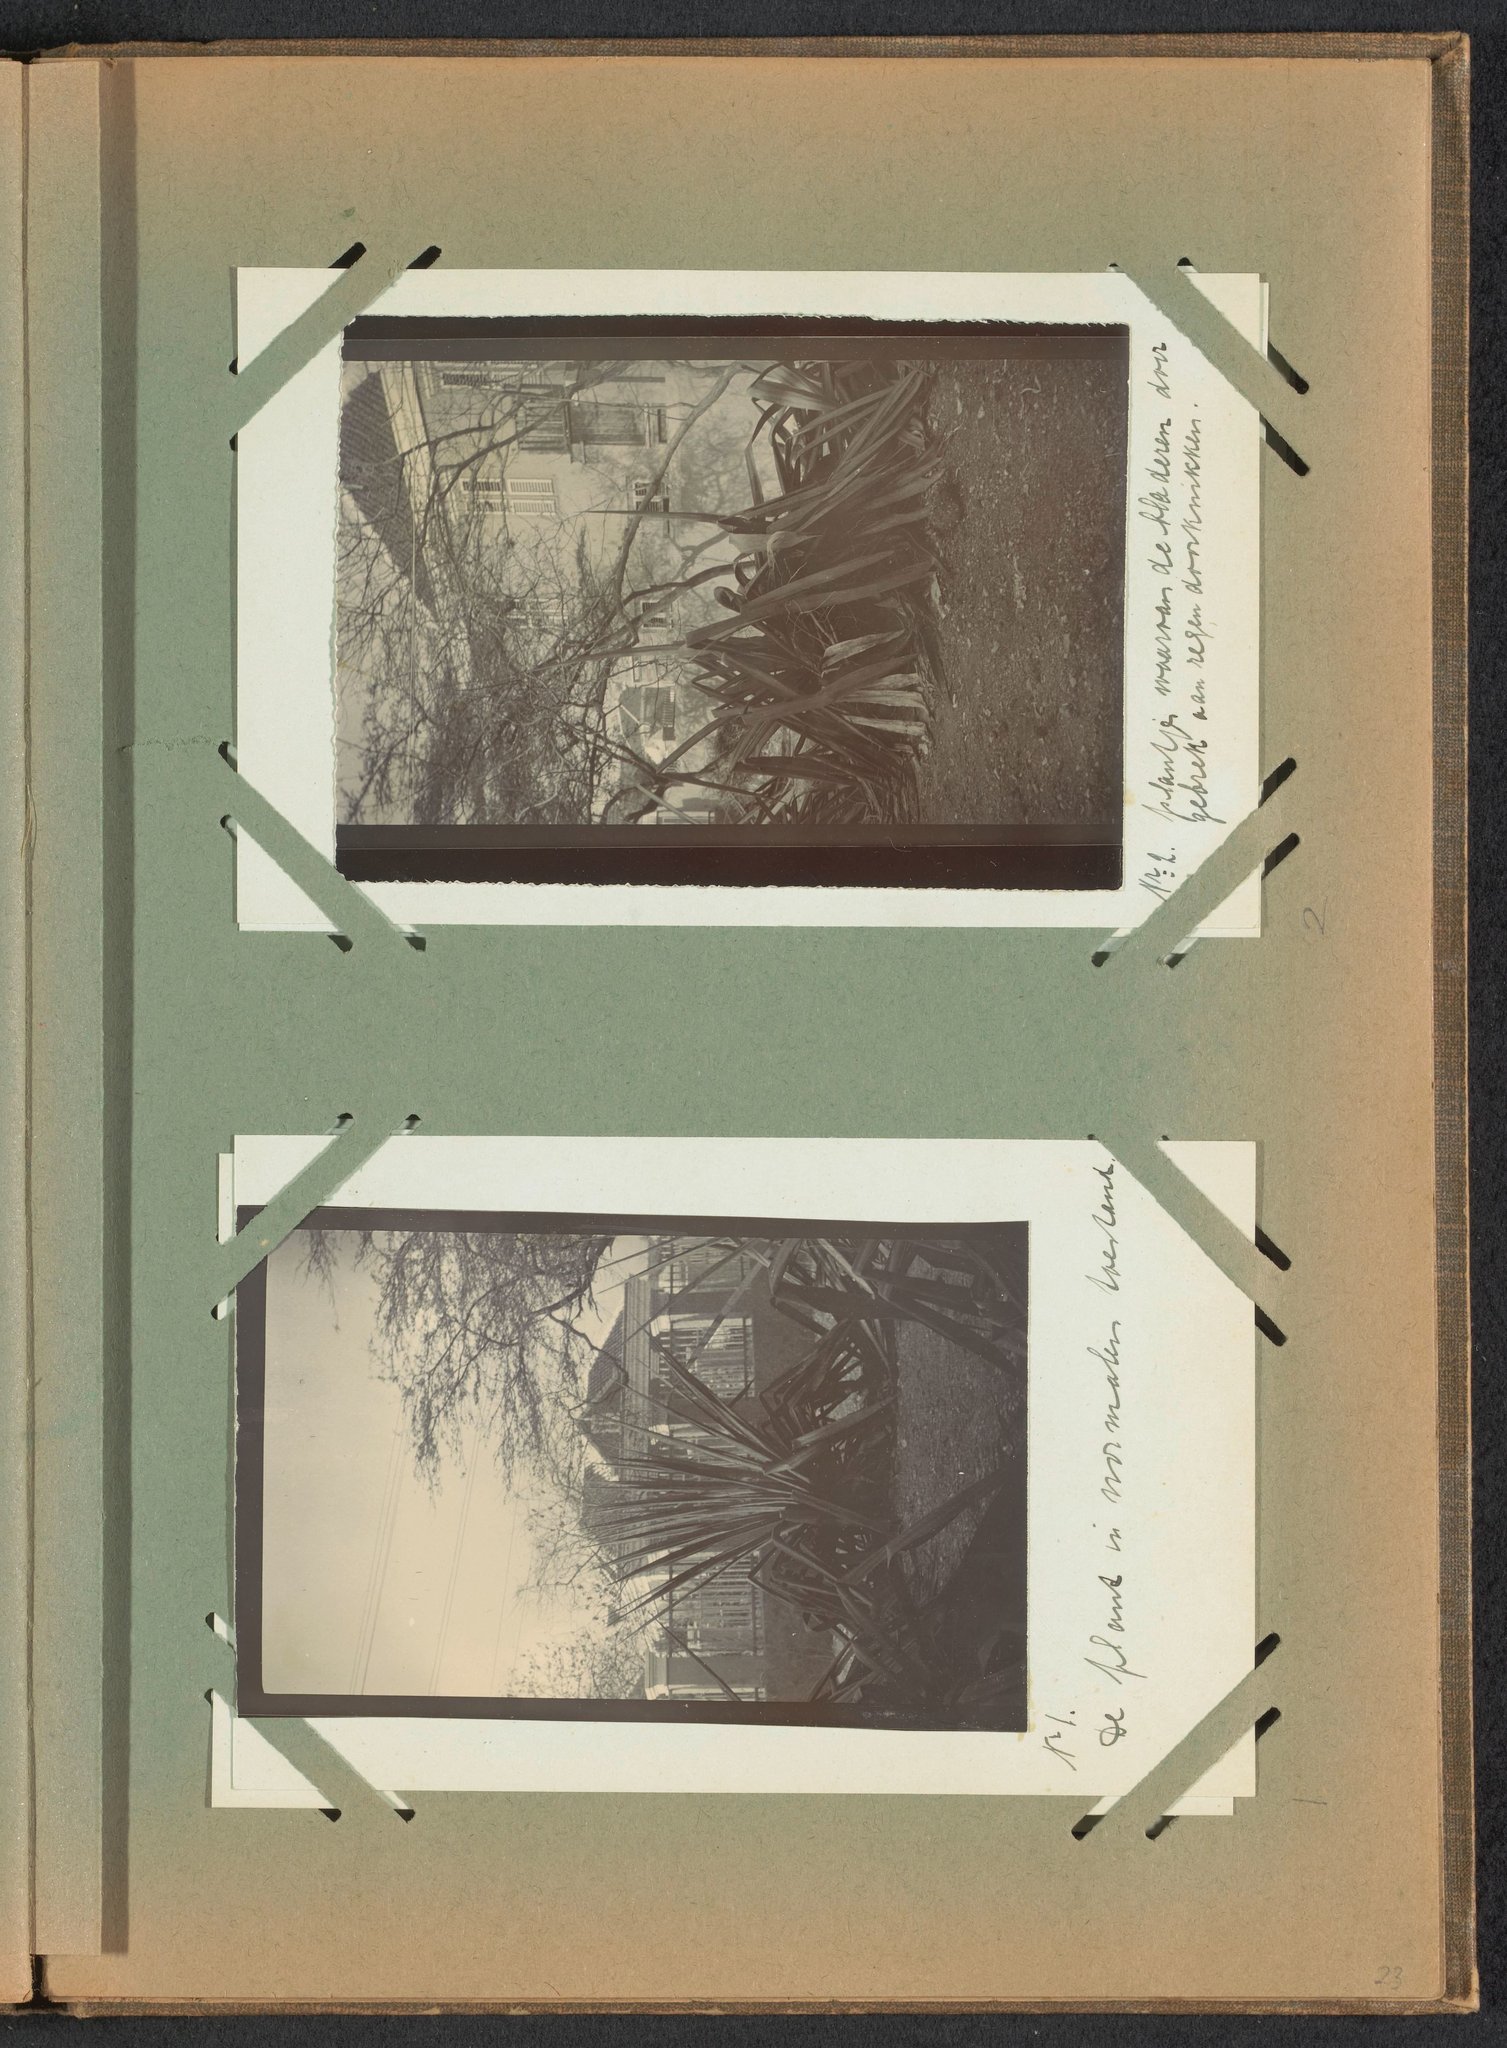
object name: photograph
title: Nr. 1 De plant in normalen toestand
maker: Anonymous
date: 1912-1913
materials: paper, photographic support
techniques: gelatin silver print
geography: curacao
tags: plantation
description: Planten voor een huis op Curaçao. Onderdeel van het fotoalbum uit ca. 1912-1913 met 92 foto's van de plantages Peperpot en Dordrecht in Suriname en Mount Pleasant op Curaçao.